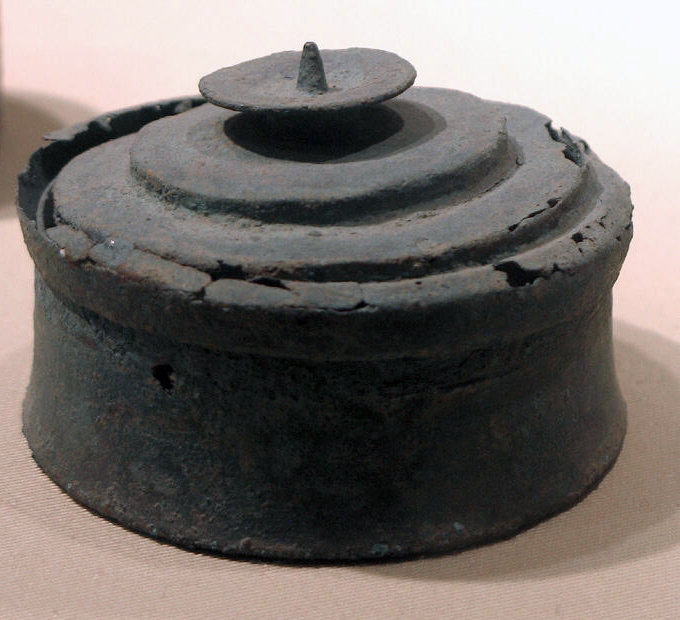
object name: reliquary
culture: gandhara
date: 1-300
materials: metal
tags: gandhara